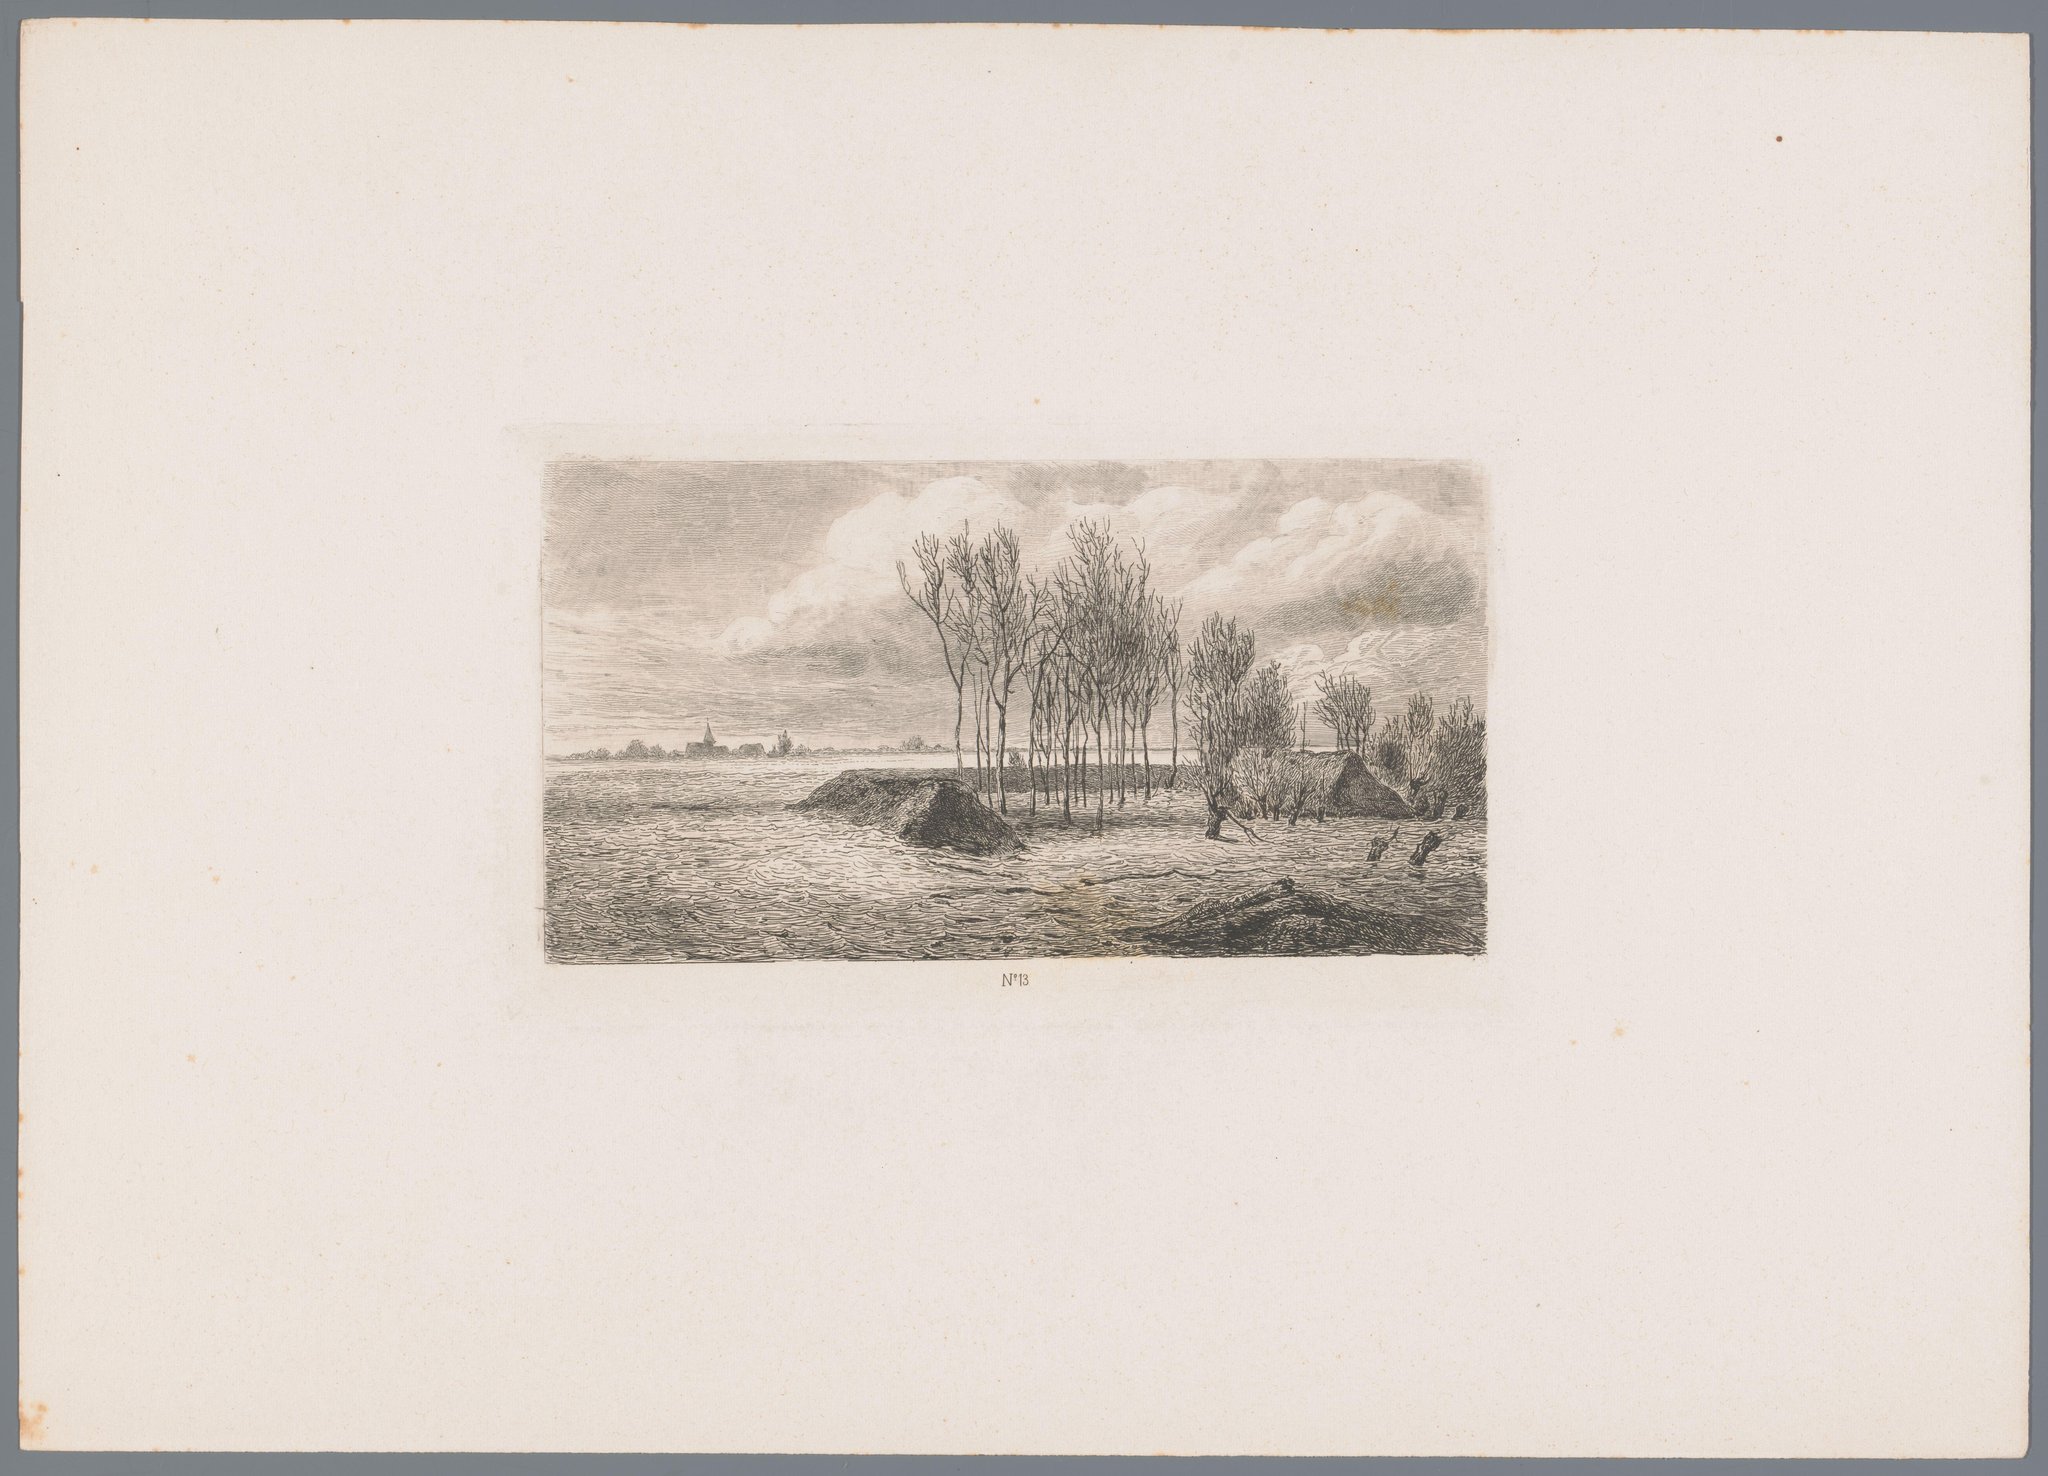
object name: print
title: De Waterramp van 1855. Geschetst in 24 afbeeldingen, naar de natuur geteekend en geëtst door leden der Maatschappij Arti et Amicitiae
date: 1855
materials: paper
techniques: etching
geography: netherlands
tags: dike-break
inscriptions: collector's mark: Lugt 2228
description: Onder water staande boerderijen bij de doorgebroken Grebbendijk bij Opheusden, 12 maart 1855. Onderdeel van de reeks van 24 prenten over de watersnood van maart 1855, door leden van het genootschap Arti et Amicitiae. Uitgave ten behoeve van de slachtoffers van de watersnood.